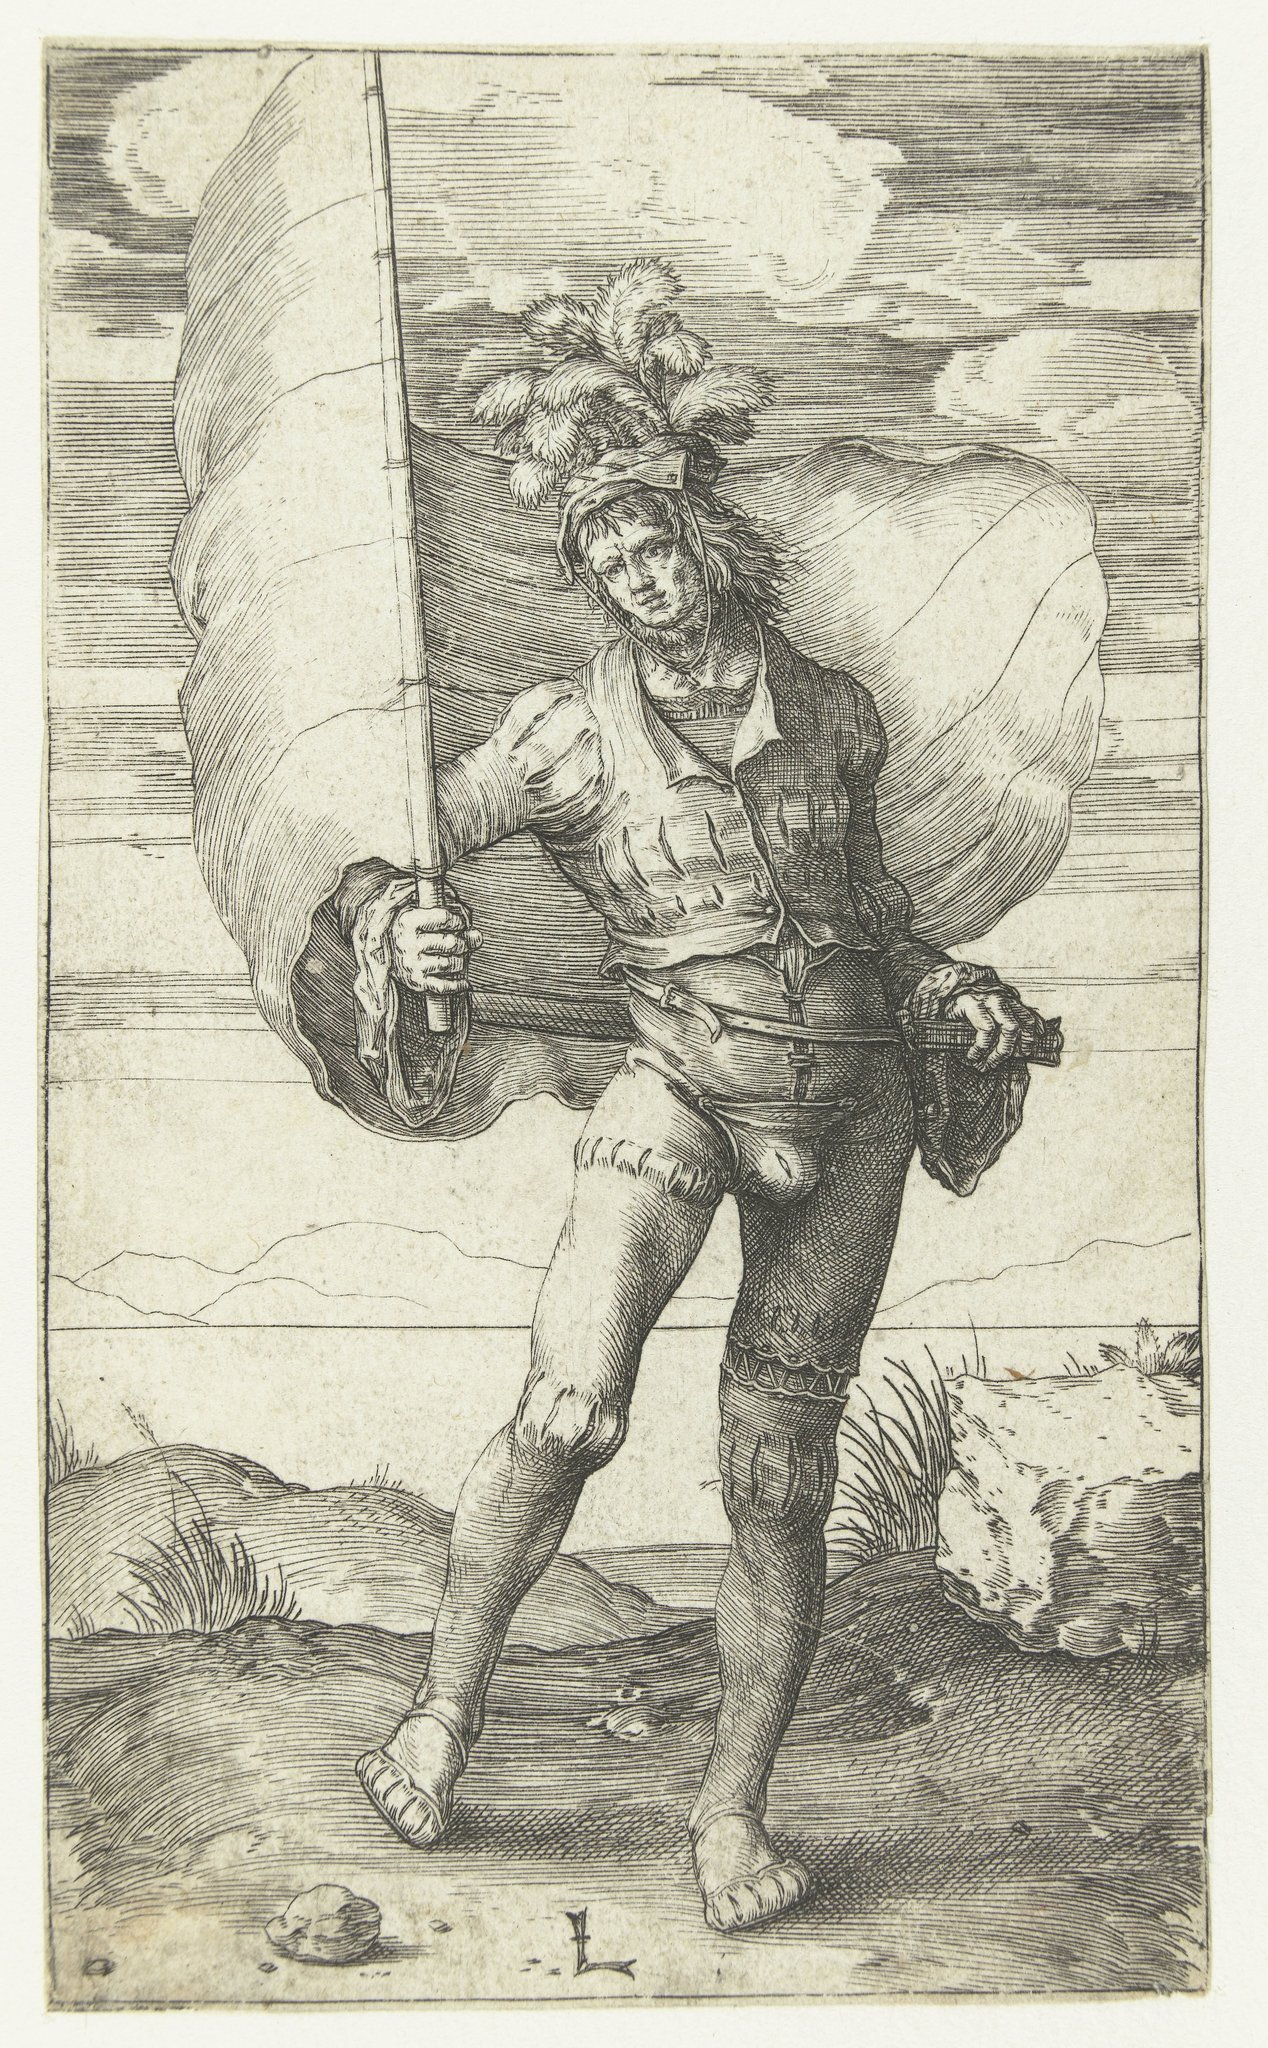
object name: print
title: De vaandeldrager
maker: lucas van leyden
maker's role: draughtsman, painter, print maker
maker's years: 1494-1533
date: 1508-1512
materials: paper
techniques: engraving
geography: low countries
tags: standard-bearer, flag-bearer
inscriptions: collector's mark: Lugt 240, signature: ‘L’